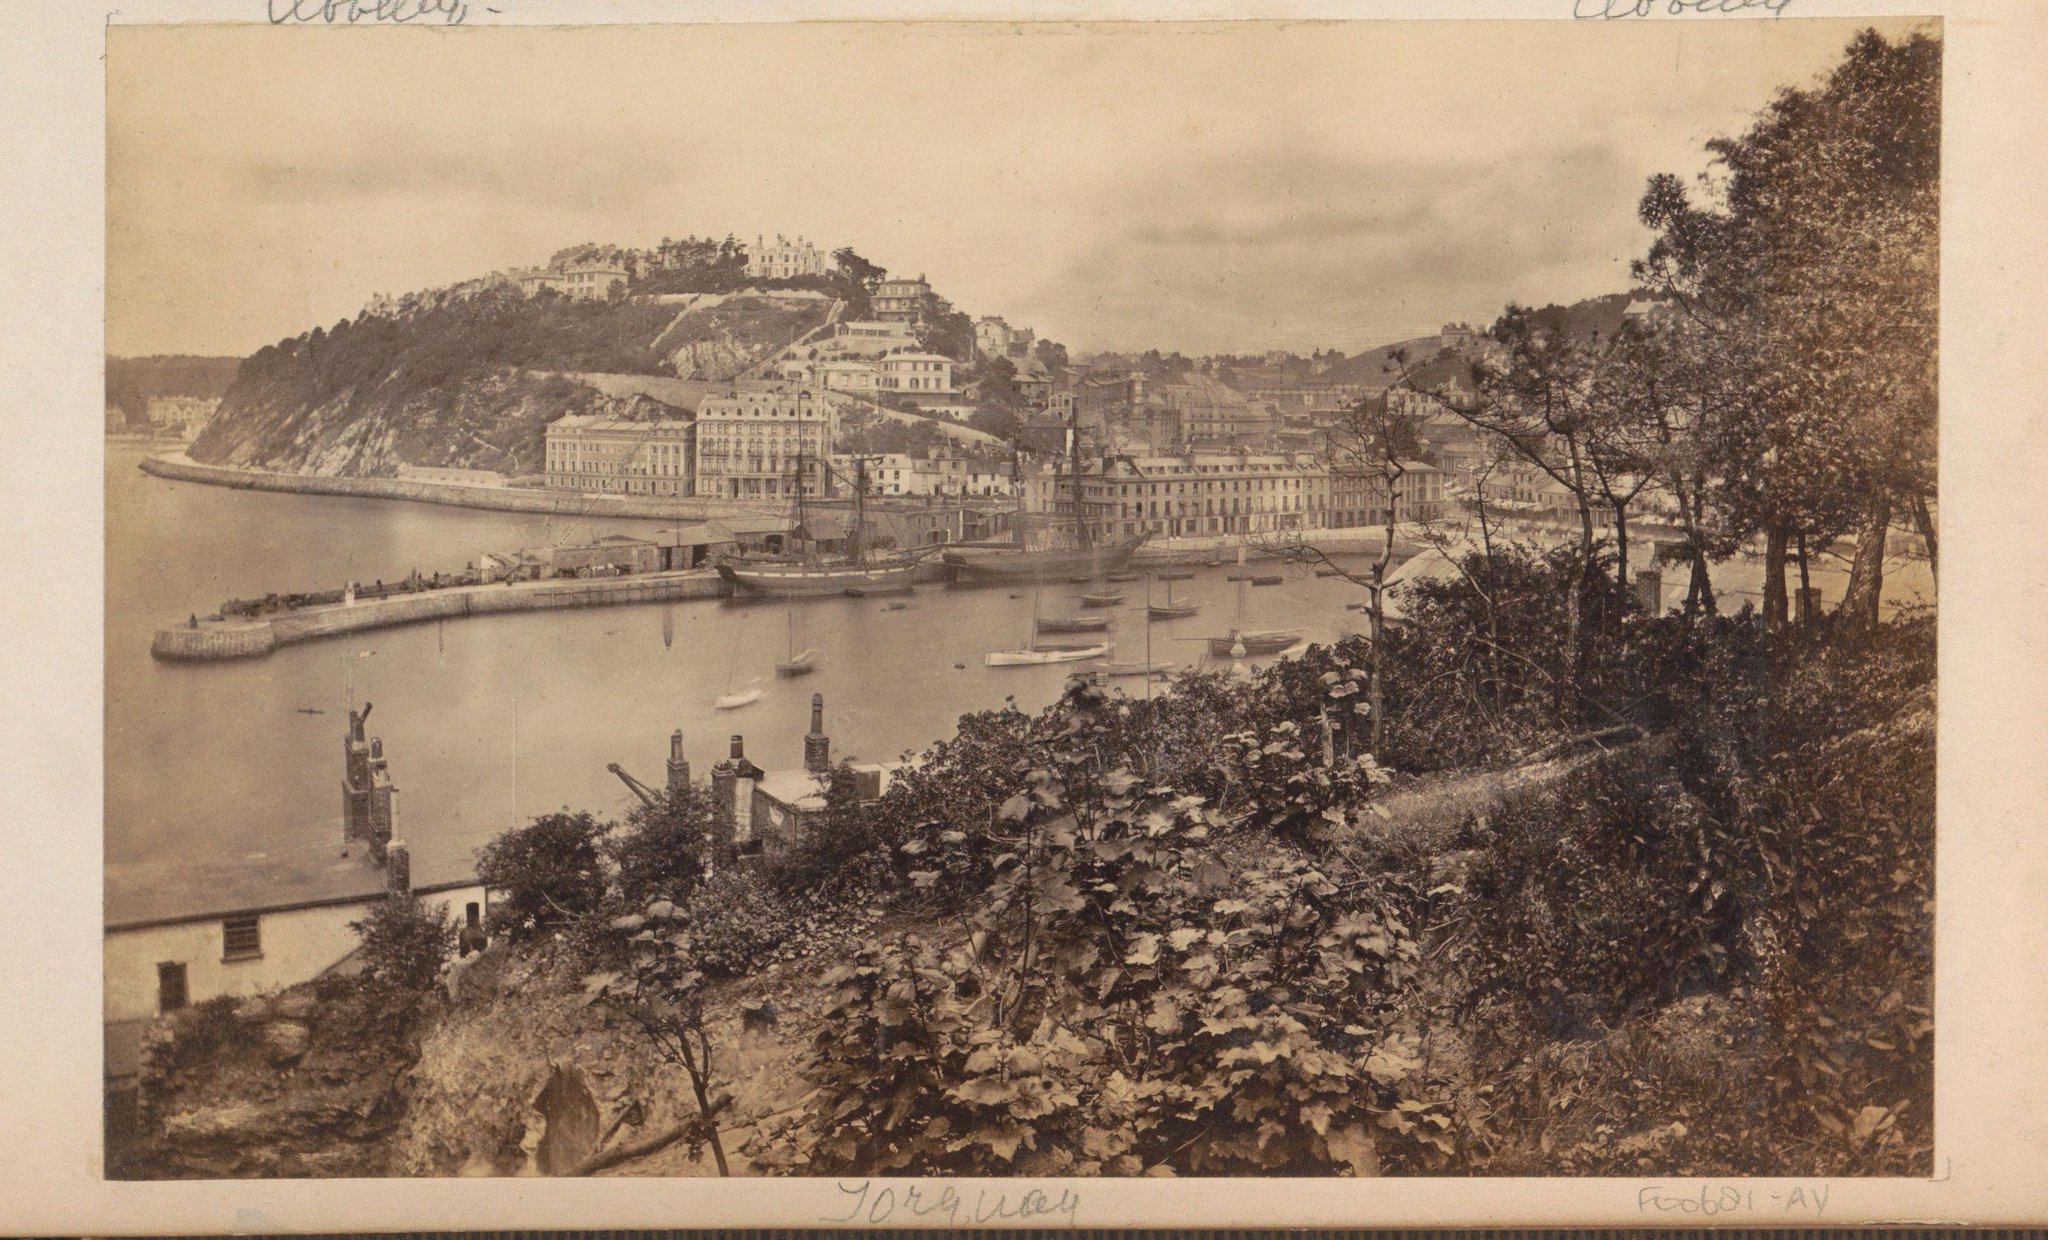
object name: photograph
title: Gezicht op de haven van Torquay met op de achtergrond Walden (Waldon) Hill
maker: Anonymous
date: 1850-1870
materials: paper, photographic support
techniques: albumen print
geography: torquay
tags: harbour (+ view ~ vehicle, ship, etc.)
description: Onderdeel van Album met foto's van bezienswaardigheden en landschappen in Engeland en van kunst.